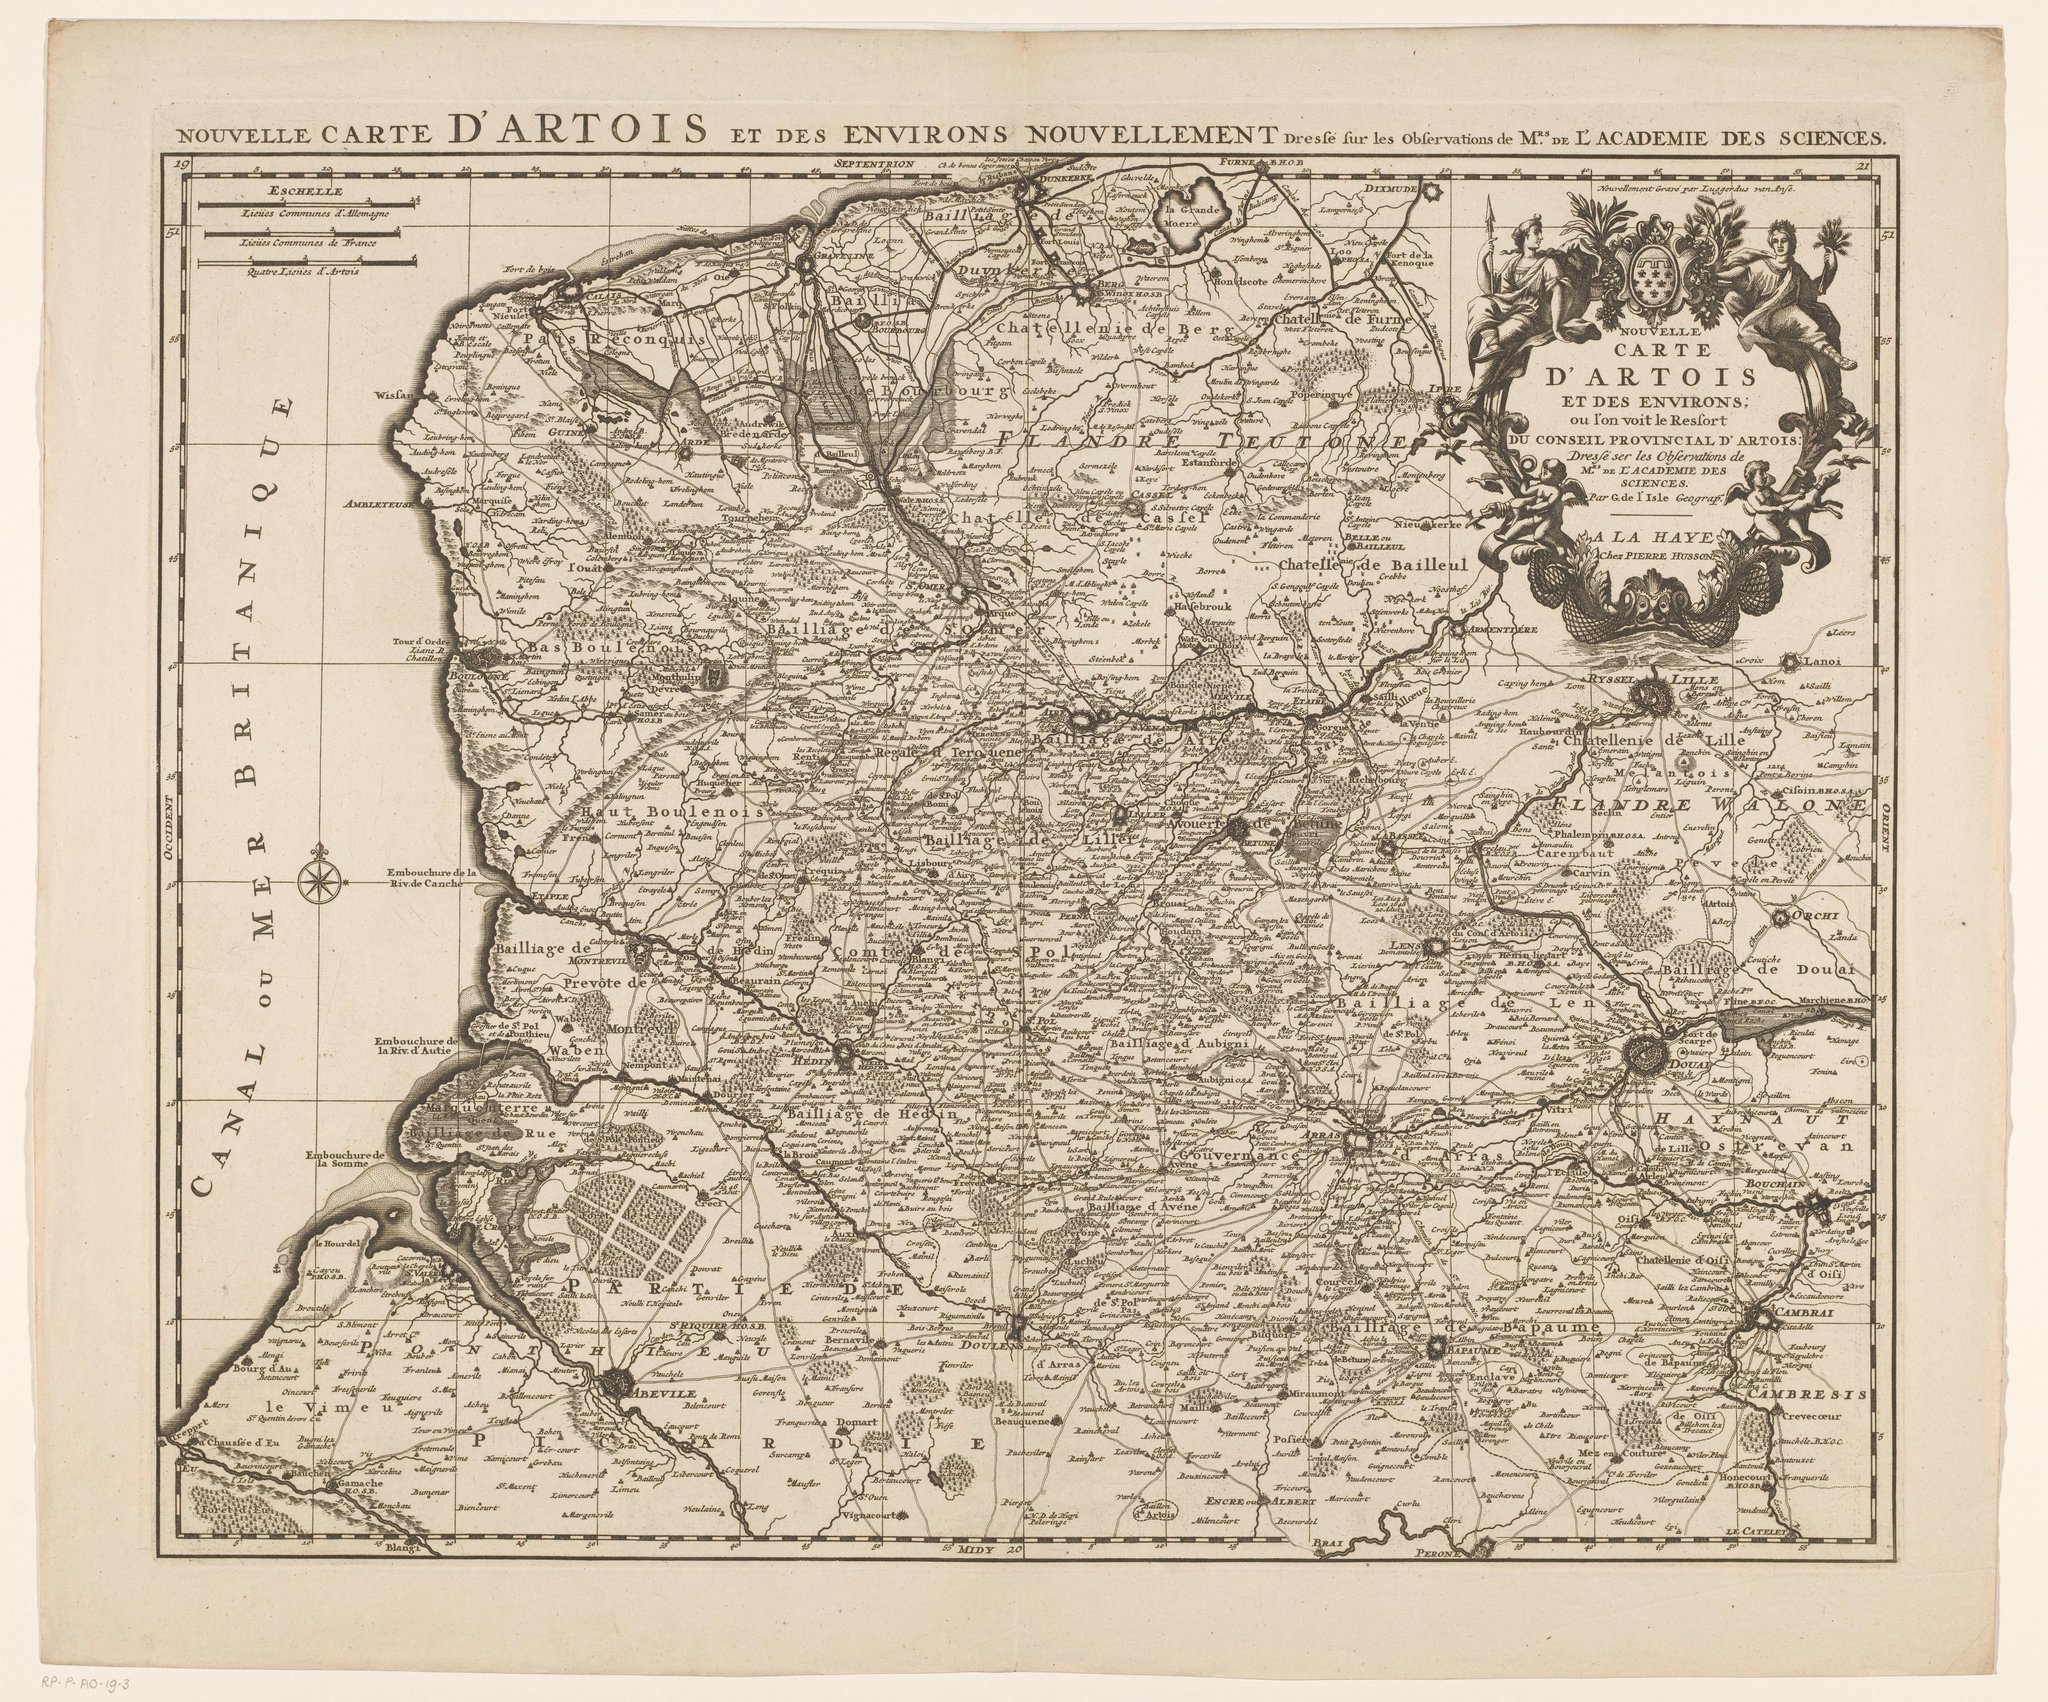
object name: print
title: Nouvelle carte d'Artois et des environs nouvellement / Nouvelle carte d'Artois et des environs; ou l'on voit le ressorts (...)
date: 1690-1732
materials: paper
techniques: engraving, etching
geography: paris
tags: maps of separate countries or regions, bird hunting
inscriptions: collector's mark: Lugt 195, collector's mark: Lugt 2228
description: Kaart van het graafschap Artesië. Rechtsboven een titelcartouche met bovenin het wapen van het graafschap Artesië. Boven de kaart nog een titel. Linksboven drie schaalstokken: Lieües Communes d'Allemagne / 3 Lieües Communes de France / Quatre Lieües d'Artois. De kaart is voorzien van een coördinaten-net en een gradenverdeling langs de randen.